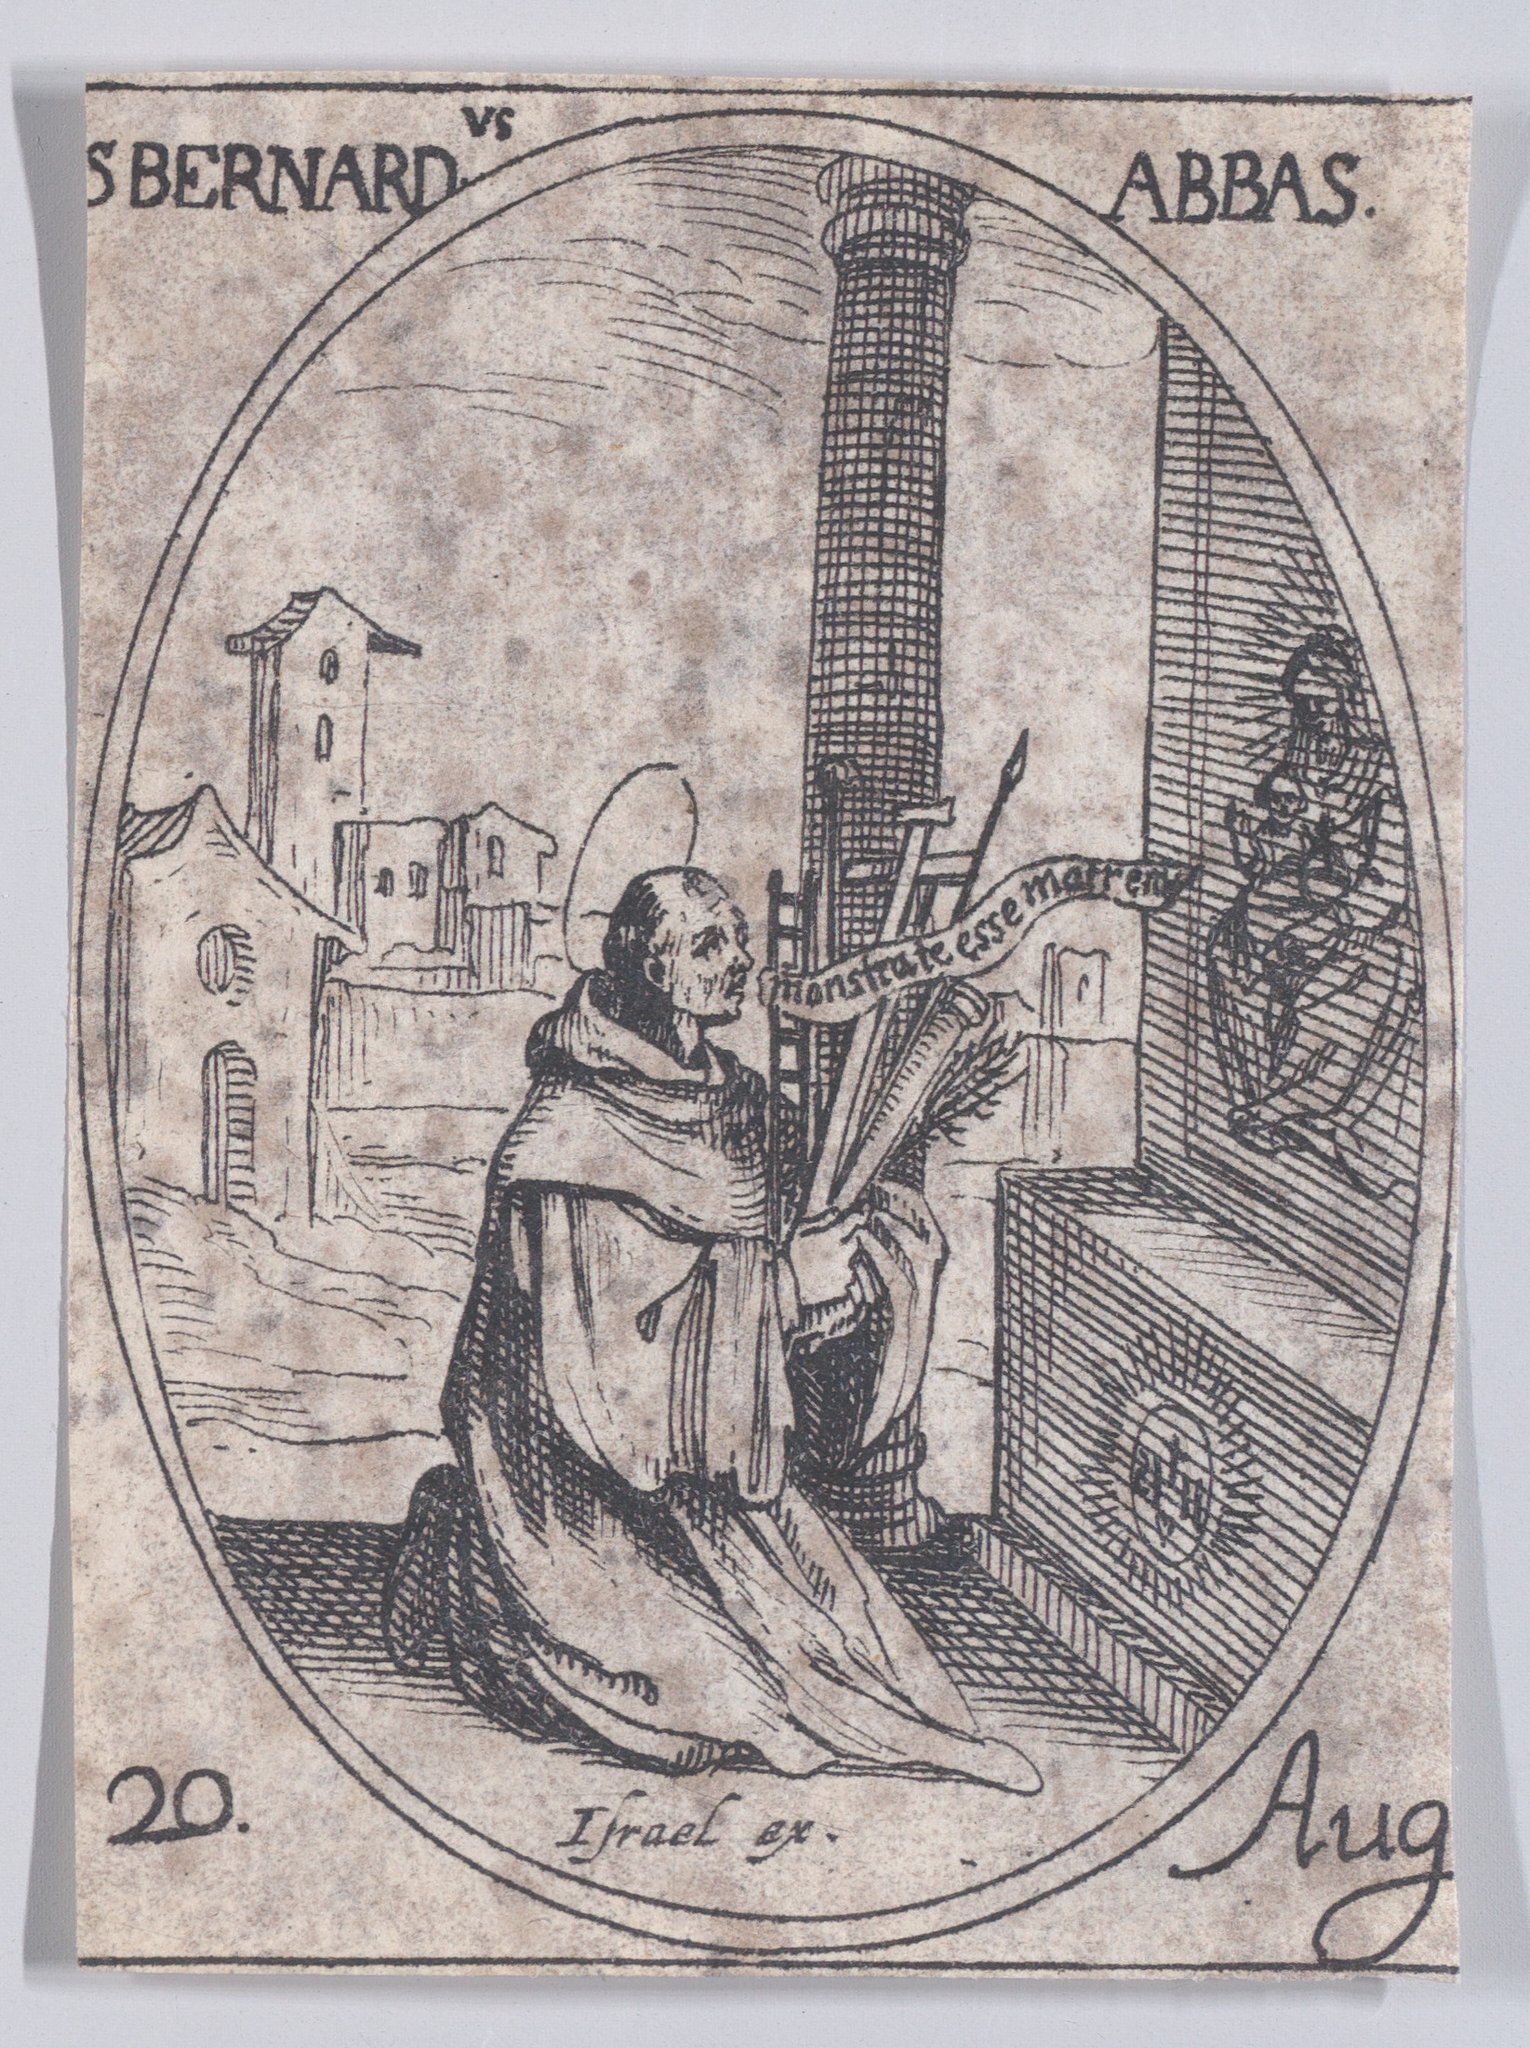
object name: print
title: S. Bernard, abbé (St. Bernard of Clairvaux, Abbot), August 20th, from "Les Images De Tous Les Saincts et Saintes de L'Année" (Images of All of the Saints and Religious Events of the Year)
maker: jacques callot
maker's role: artist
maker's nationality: french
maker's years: 1592-1635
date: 1636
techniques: etching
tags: men,saints